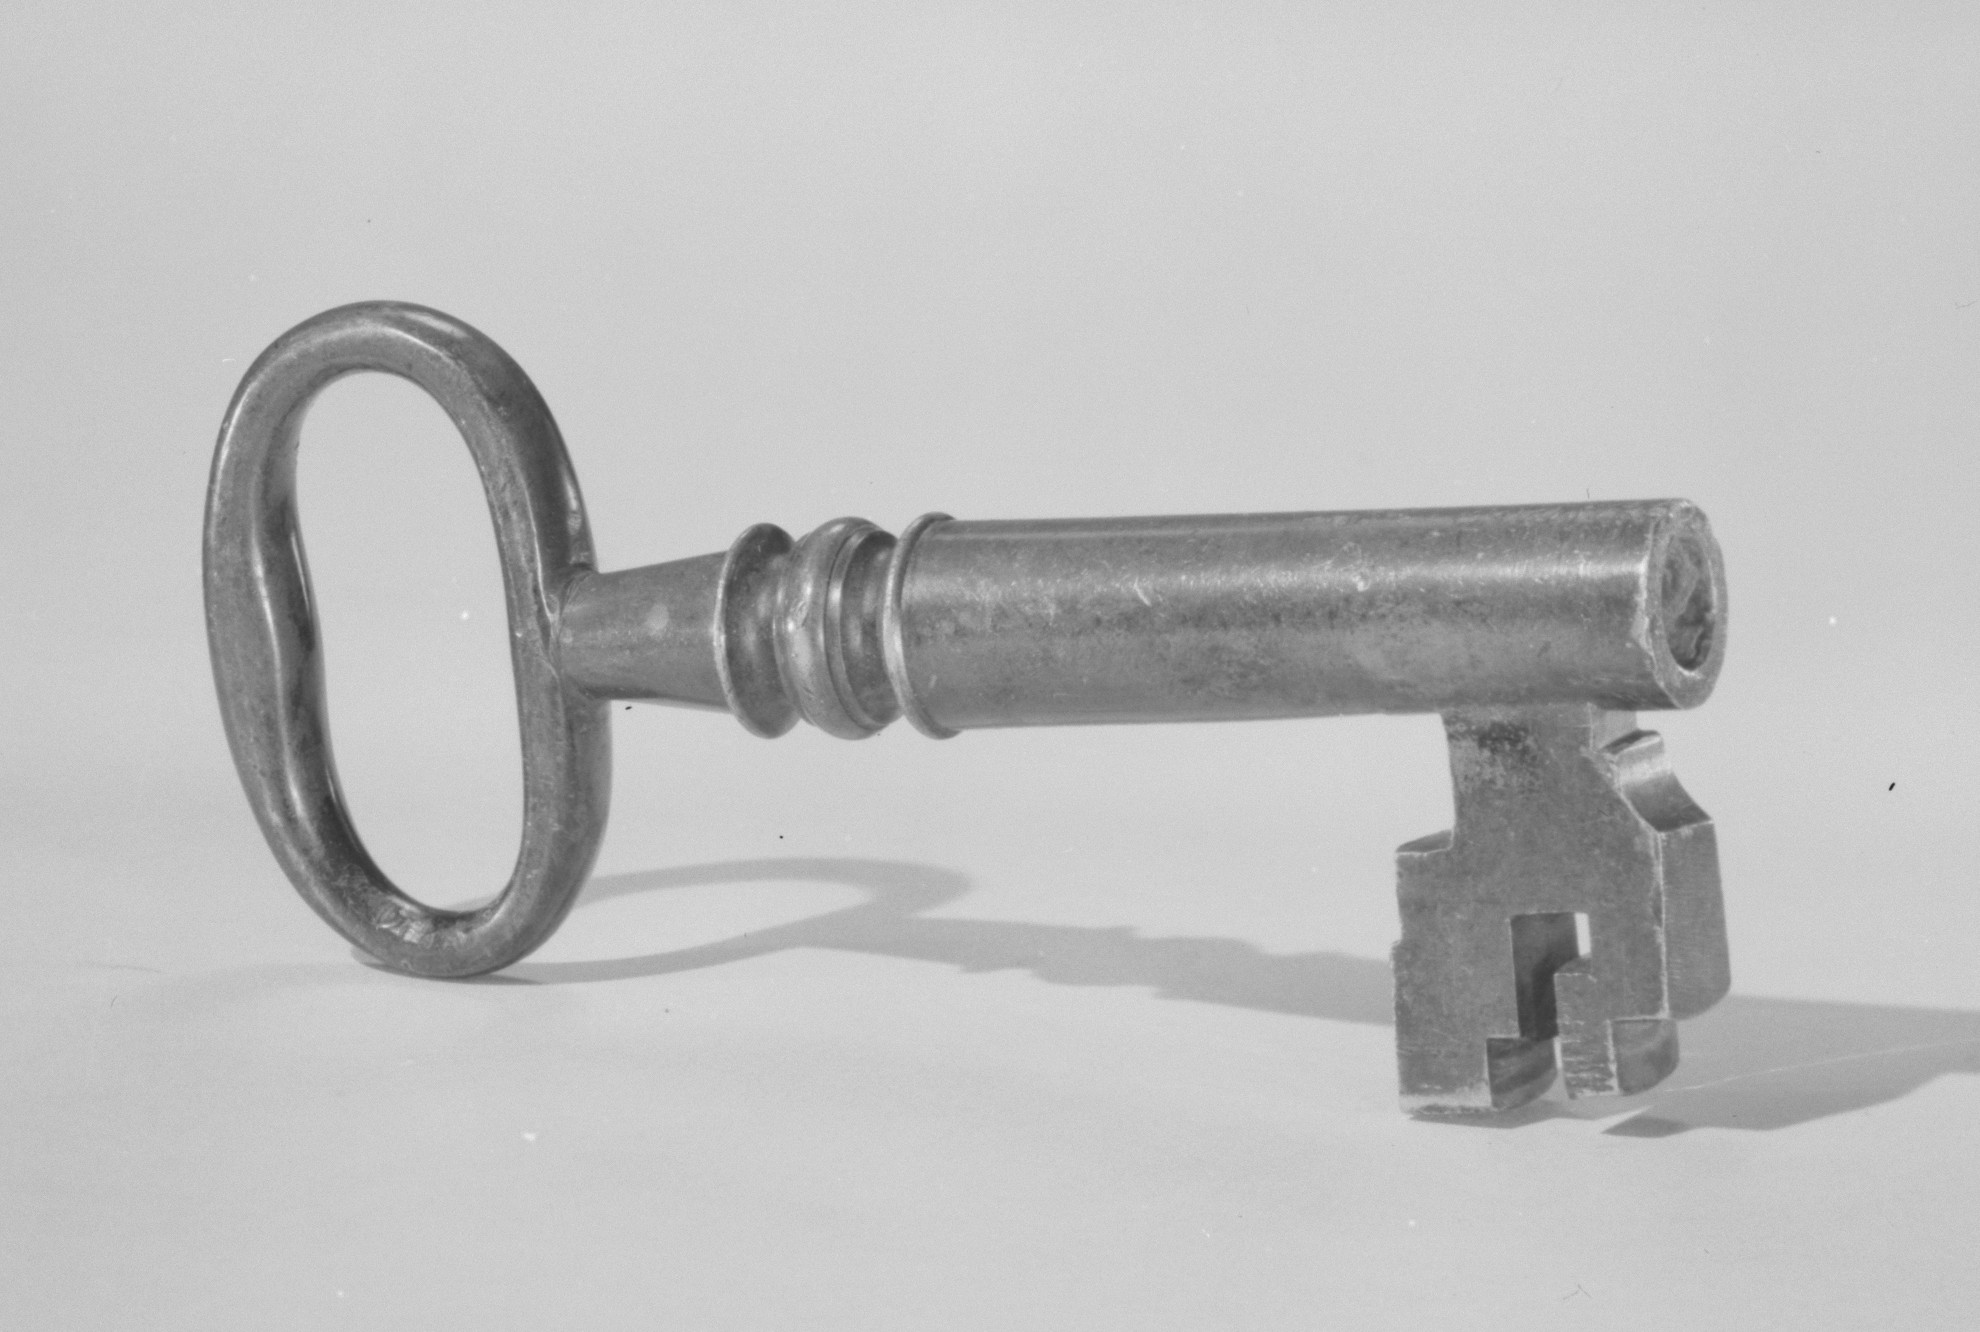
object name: key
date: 1767-1900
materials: brass